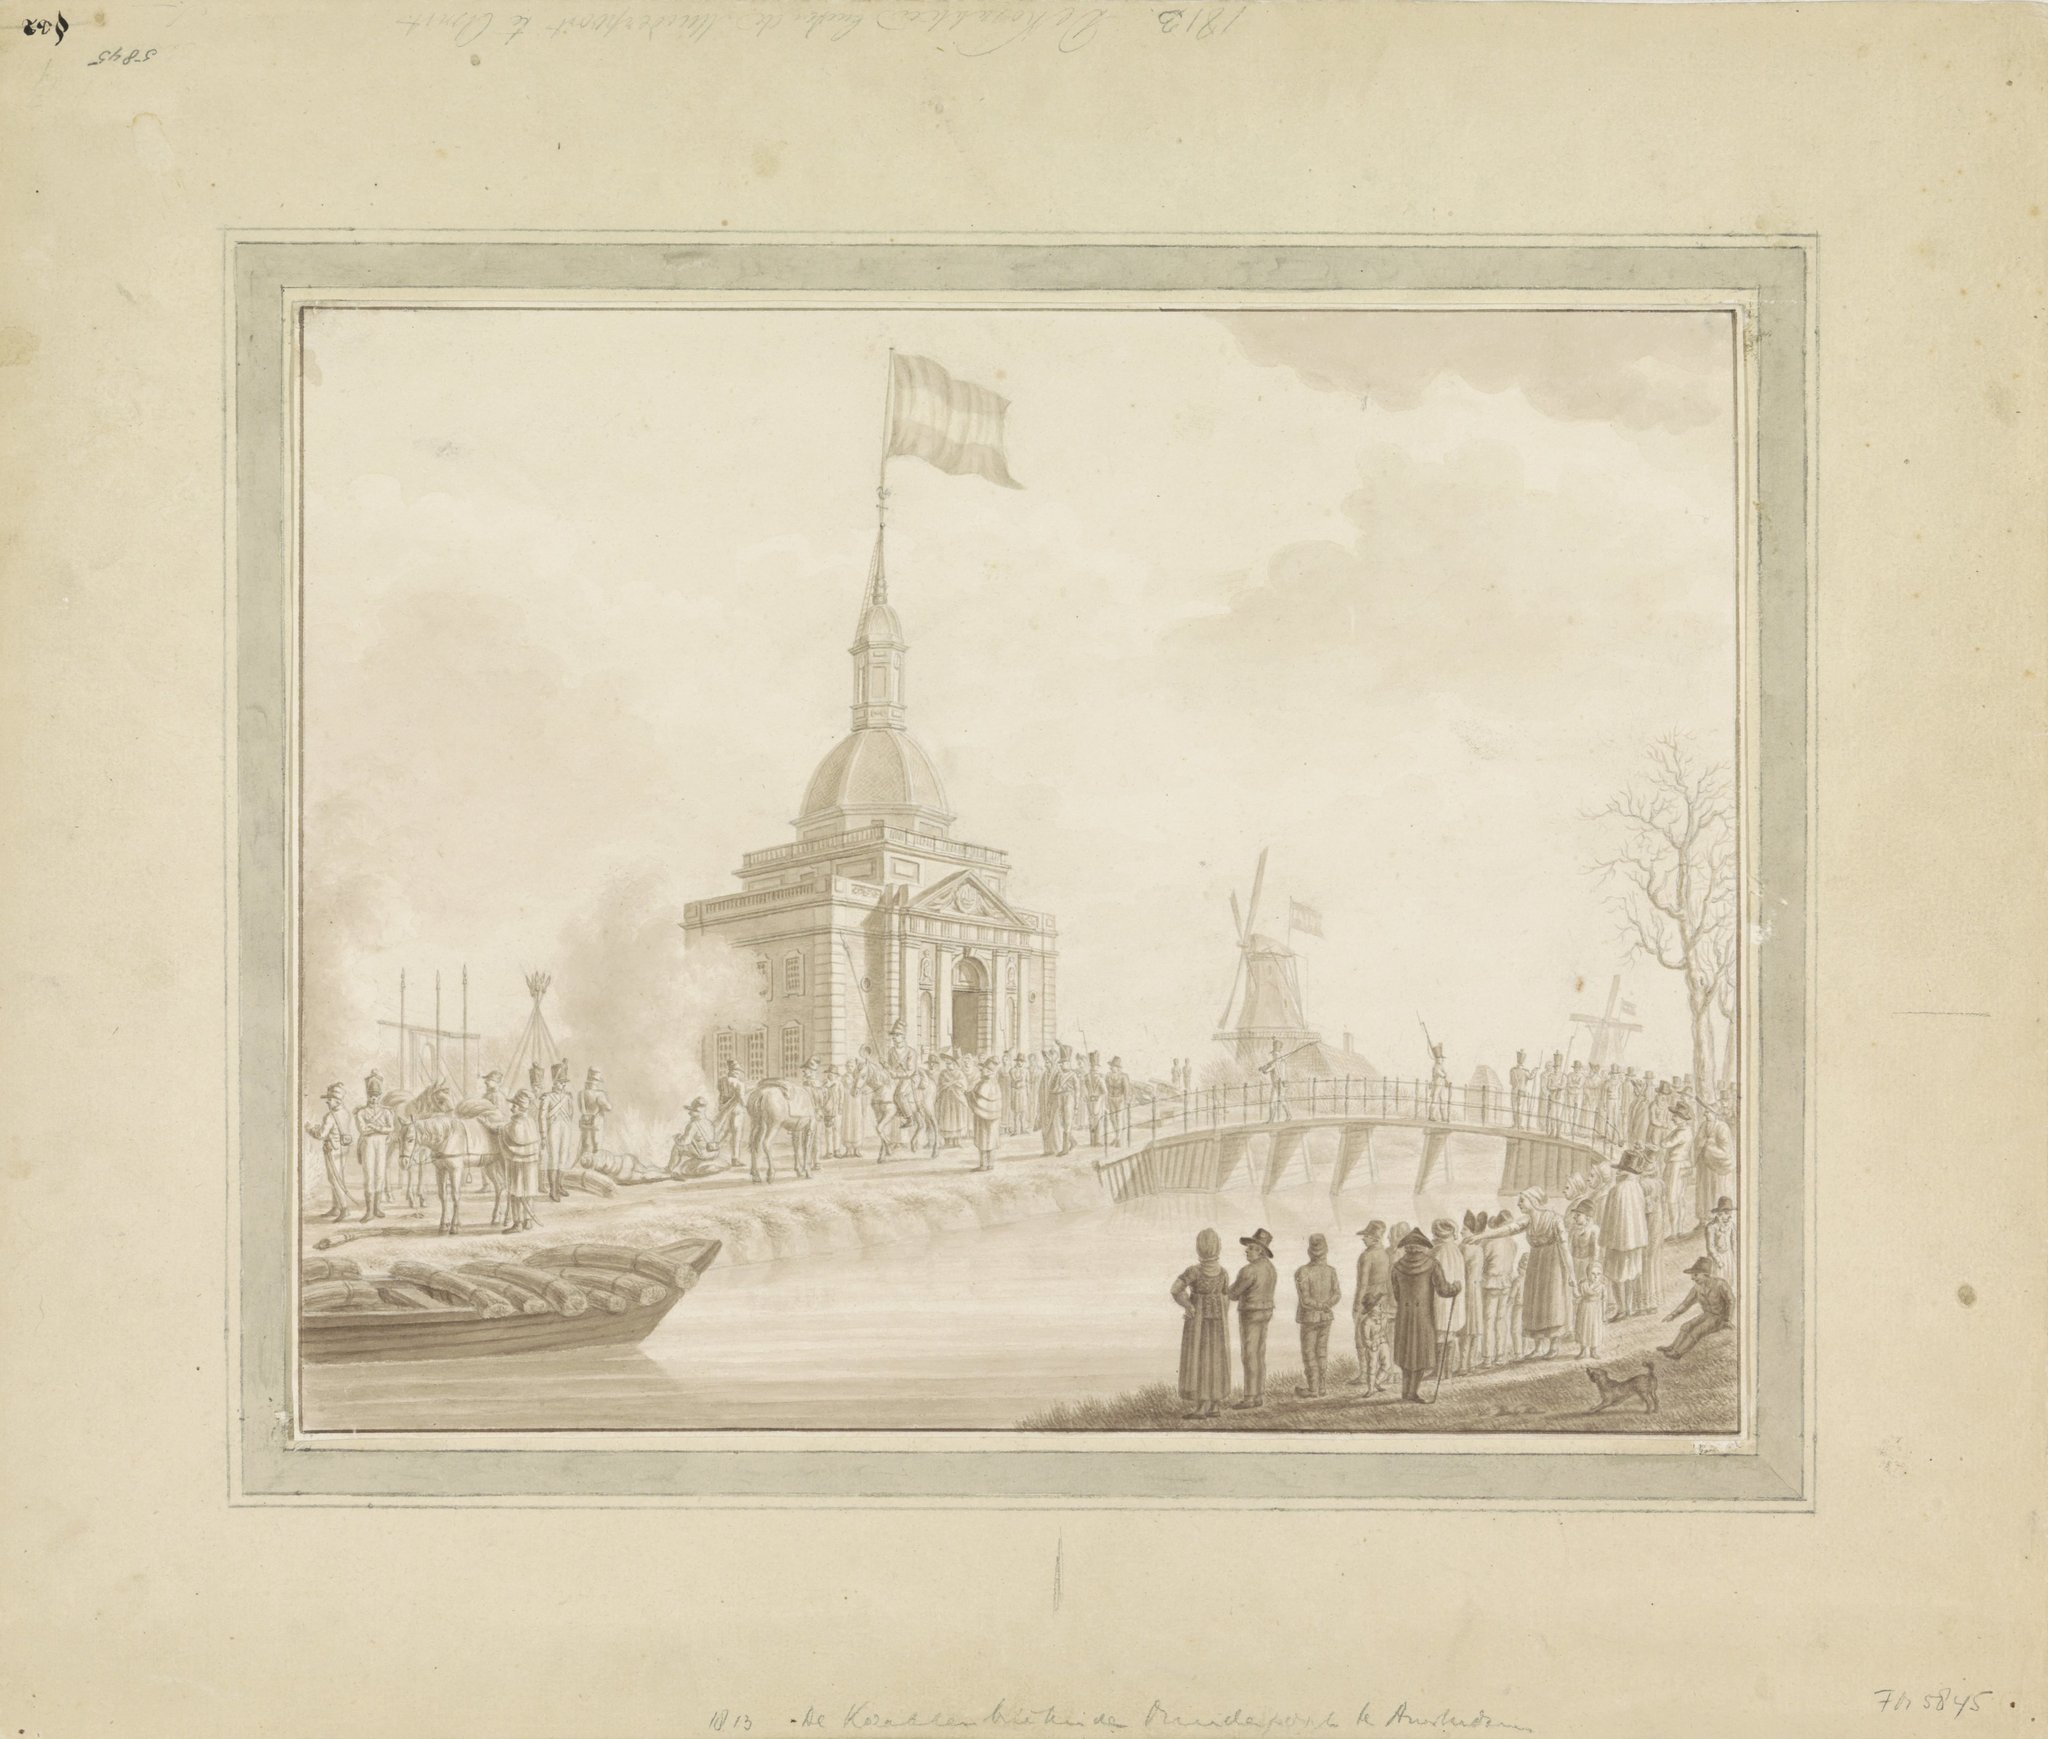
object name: drawing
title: Kozakken bivak bij Amsterdam, 1813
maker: Anonymous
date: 1813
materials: paper, pencil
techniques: brush, pen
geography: netherlands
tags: (military) camp with tents, canteen ~ the soldier off duty, kitchen-fire - cc - in the open air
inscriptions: collector's mark: Lugt 2228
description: Bivak van de kozakken binnen de Muiderpoort bij Amsterdam, 24 november 1813. Soldaten en burgers verzameld bij de poort en rond een kampvuur. Gezicht op de Muiderpoort vanaf de Plantage.